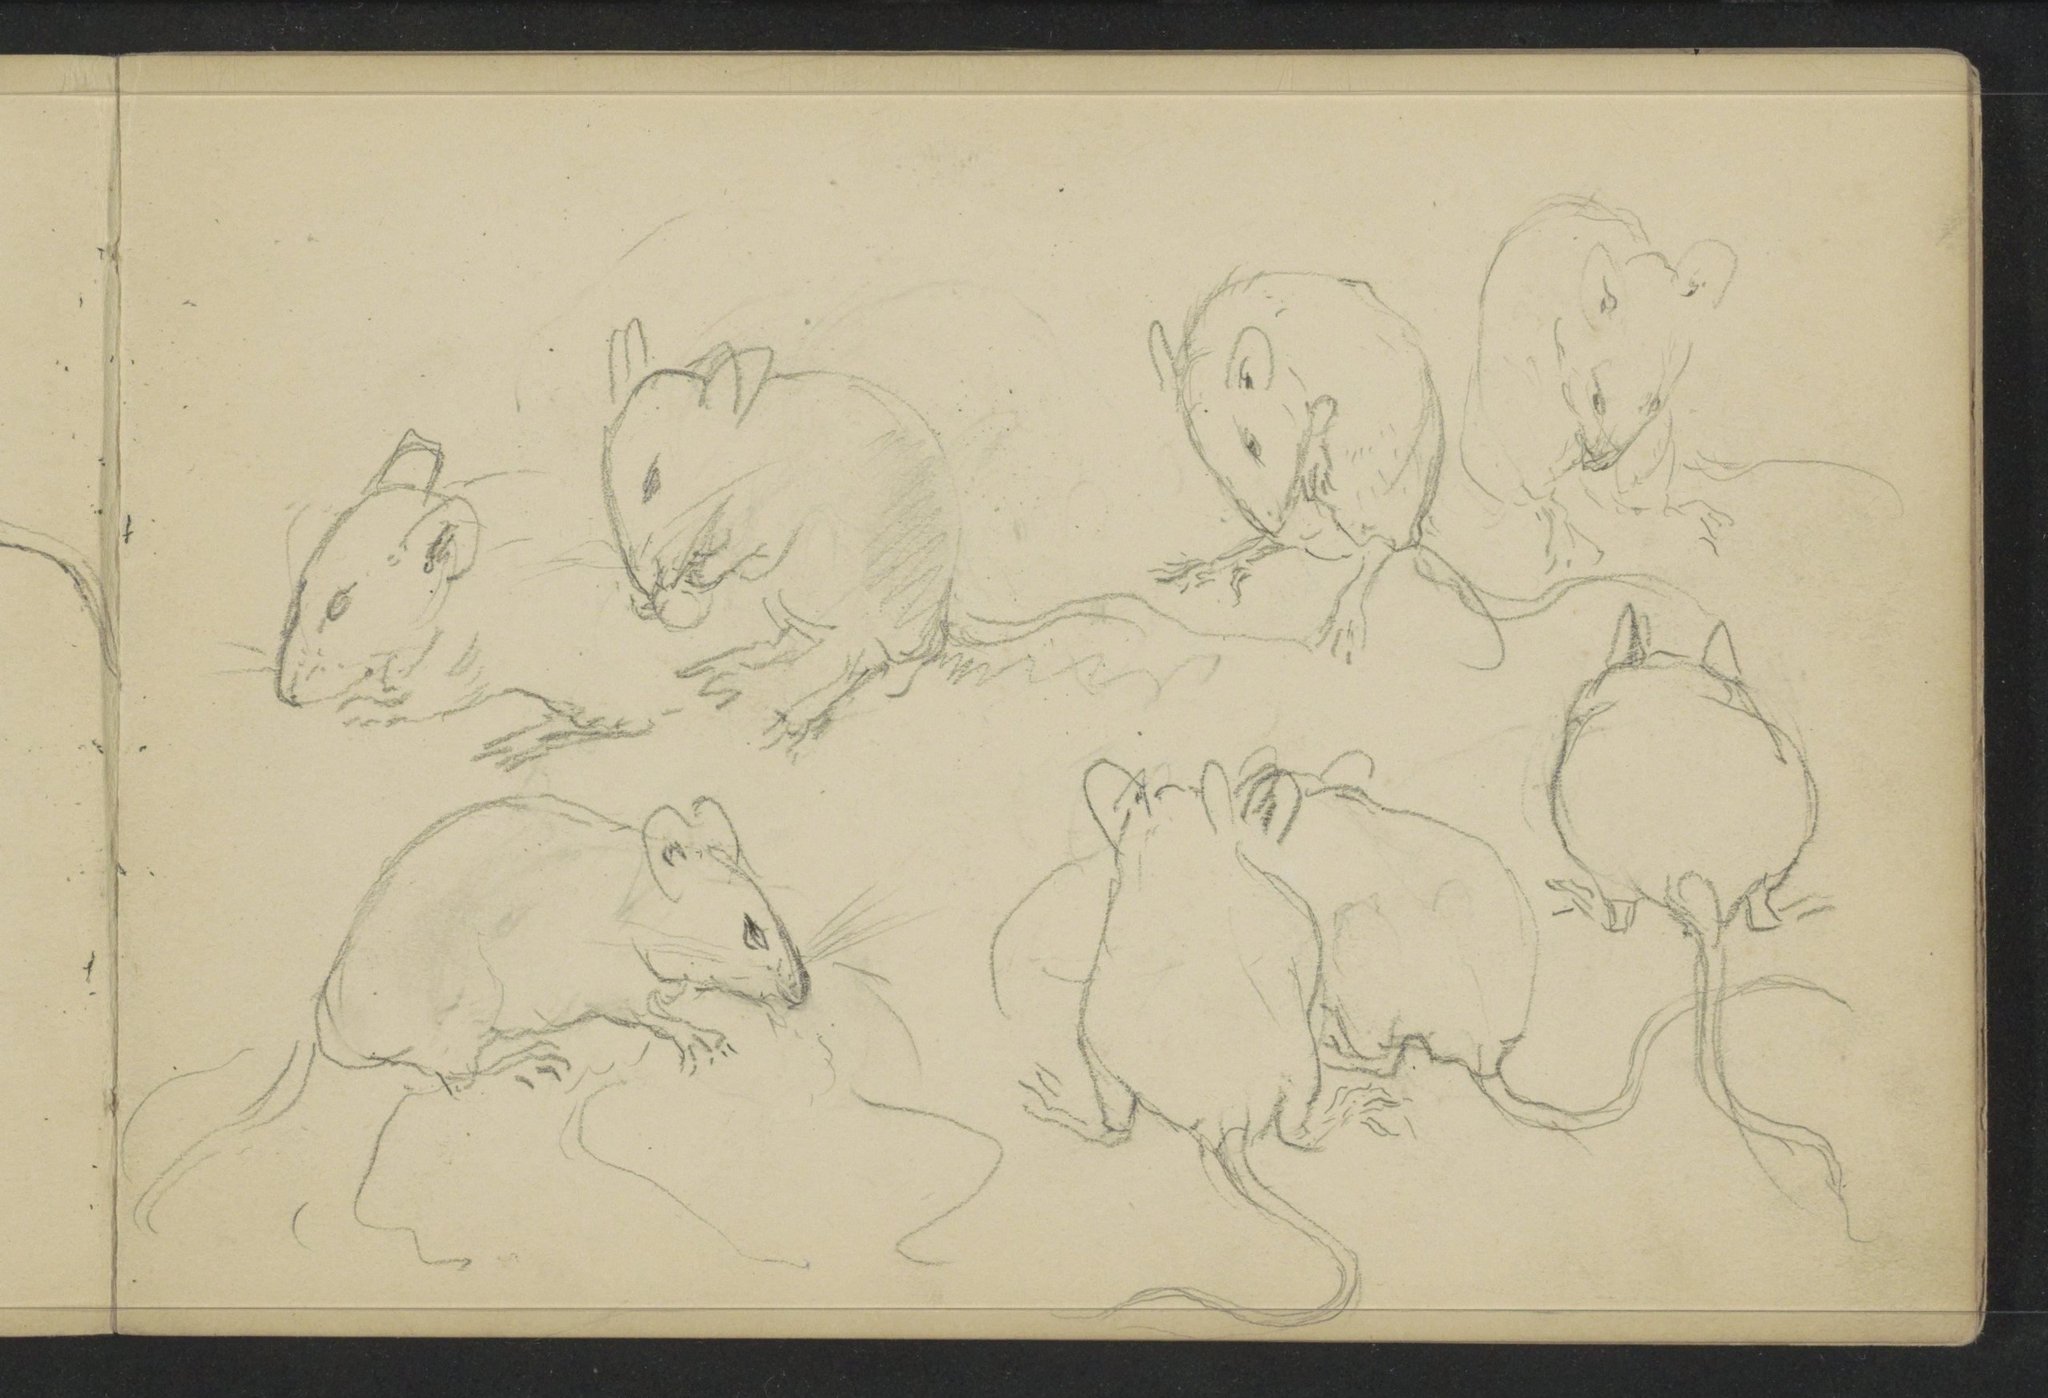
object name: sketchbook leaf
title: Muizen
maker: johanna van de kamer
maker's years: 1873-1922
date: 1883-1922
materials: paper, pencil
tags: rodents: mouse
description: Blad 4 recto uit een schetsboek met 13 bladen.